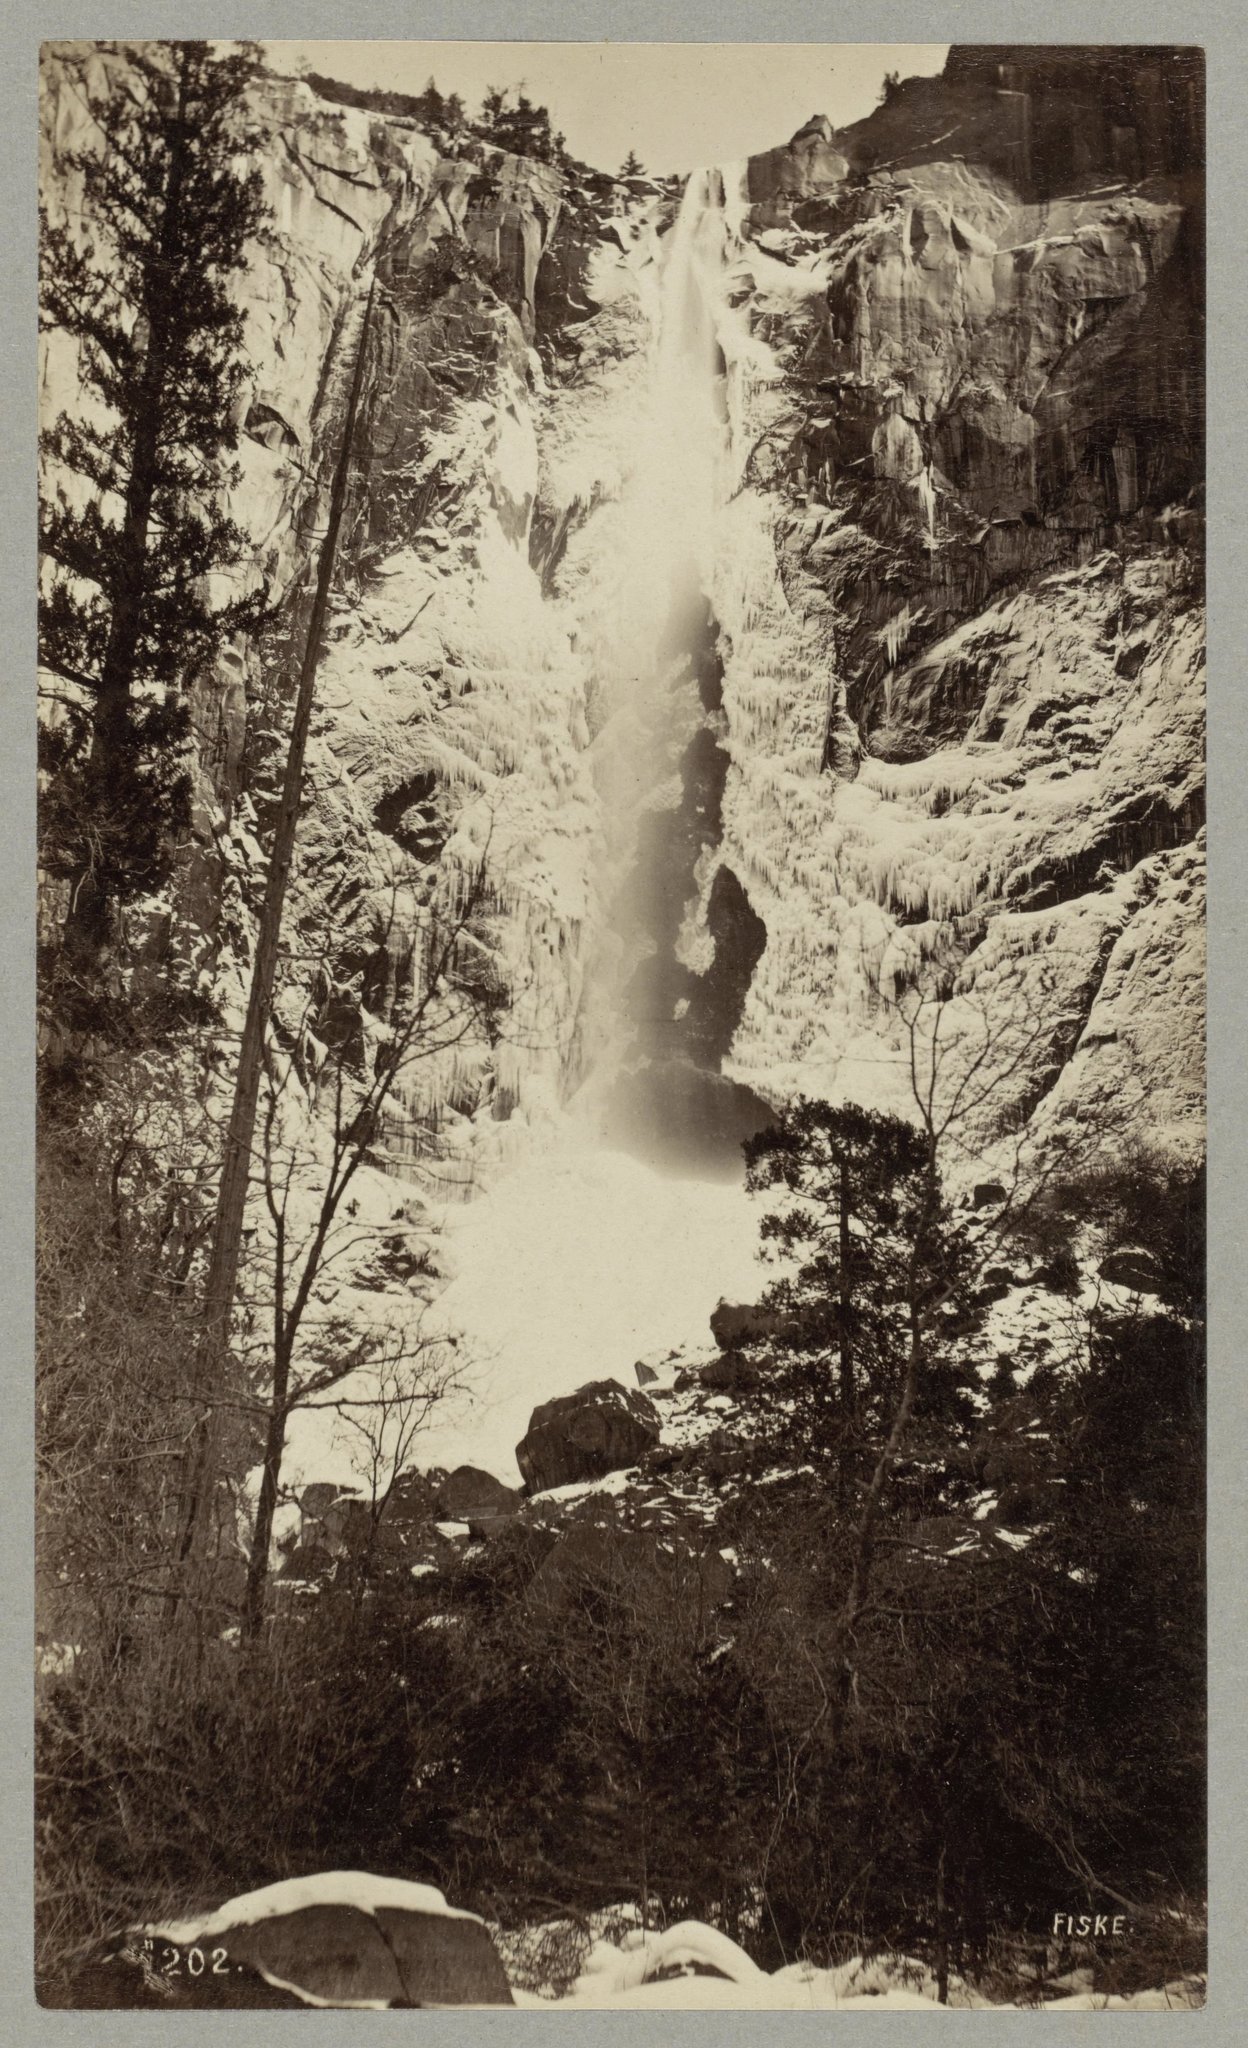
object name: photograph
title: Bevroren waterval in de Verenigde Staten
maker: george fiske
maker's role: fotograaf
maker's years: 1835-1918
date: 1880-1900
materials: cardboard, paper, photographic support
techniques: albumen print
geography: united states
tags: waterfall, ice ~ state of water, united states of america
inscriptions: negative number: ‘202’